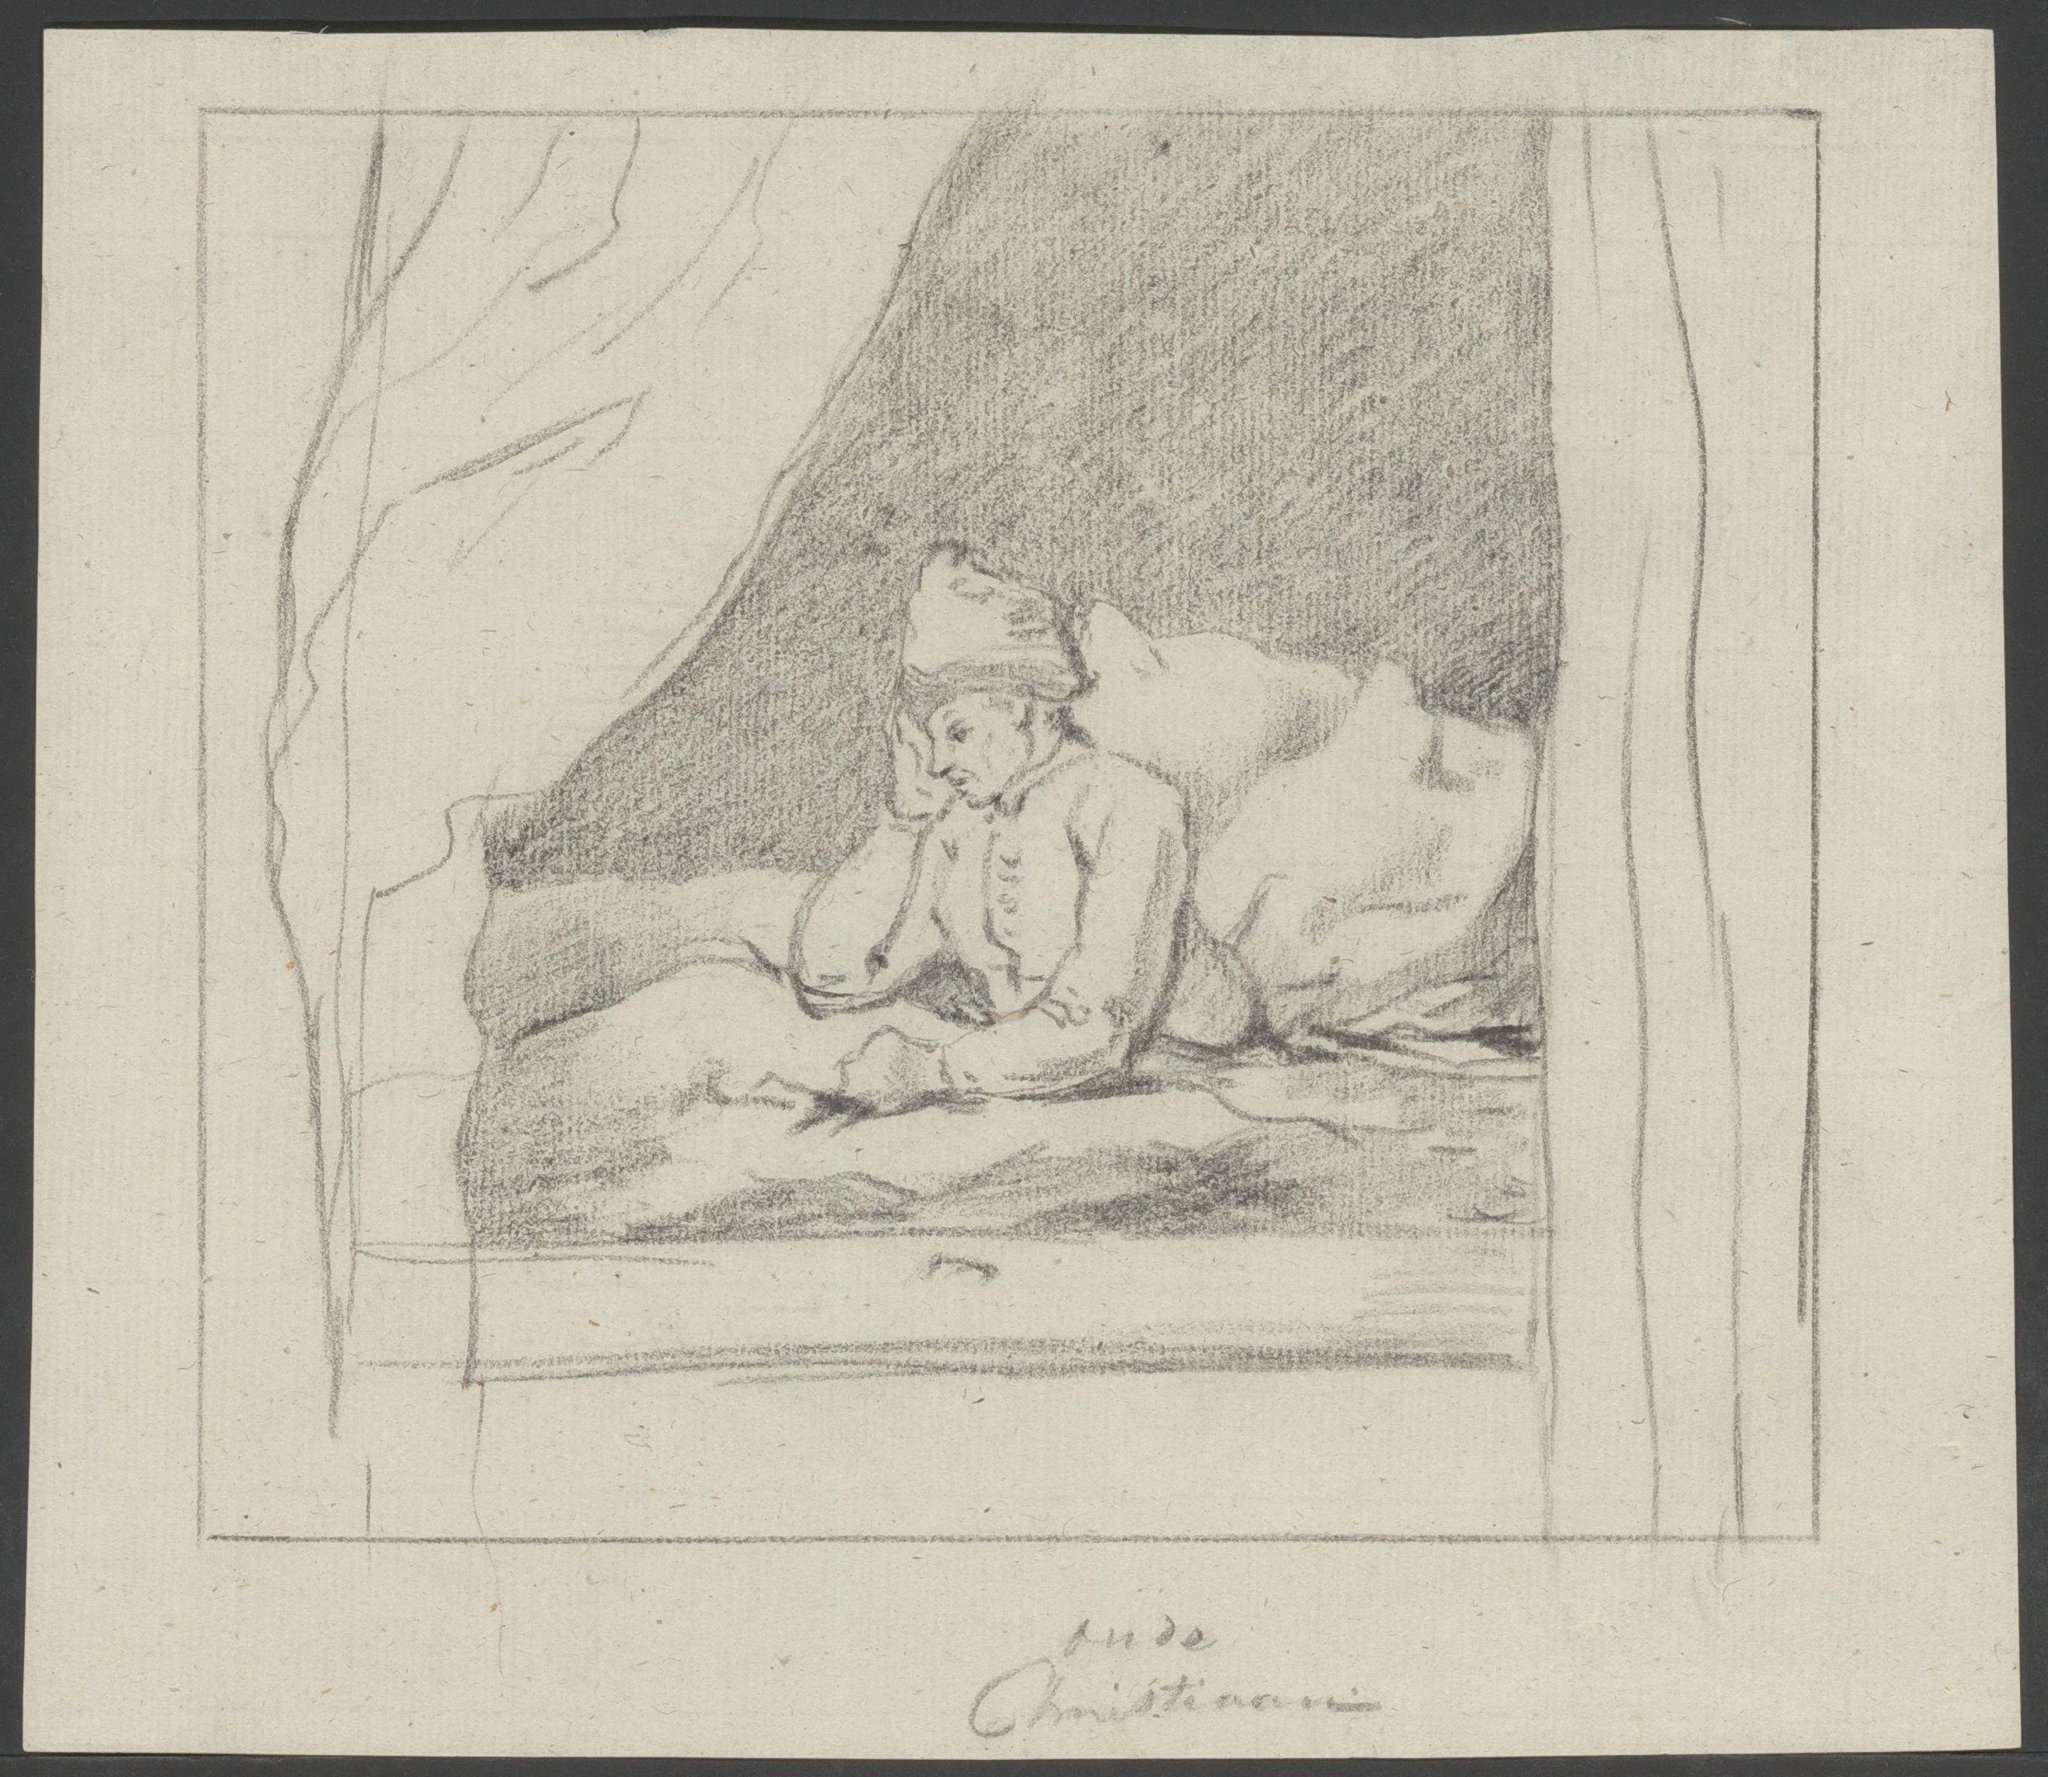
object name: drawing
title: Man in een bedstee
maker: jean bernard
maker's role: draughtsman, print maker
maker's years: 1765-1833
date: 1775-1833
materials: chalk, paper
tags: nightwear: night-cap, sitting on an elevation, built-in bedstead (dutch: 'bedstee')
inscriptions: collector's mark: Lugt 1641, stamp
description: Man met slaapmuts in een bedstee. Onderwerpsrubrieken binnen de Atlas Zeden en Gewoonten: Schoone kunsten, Schilderkunst, Tekeningen.